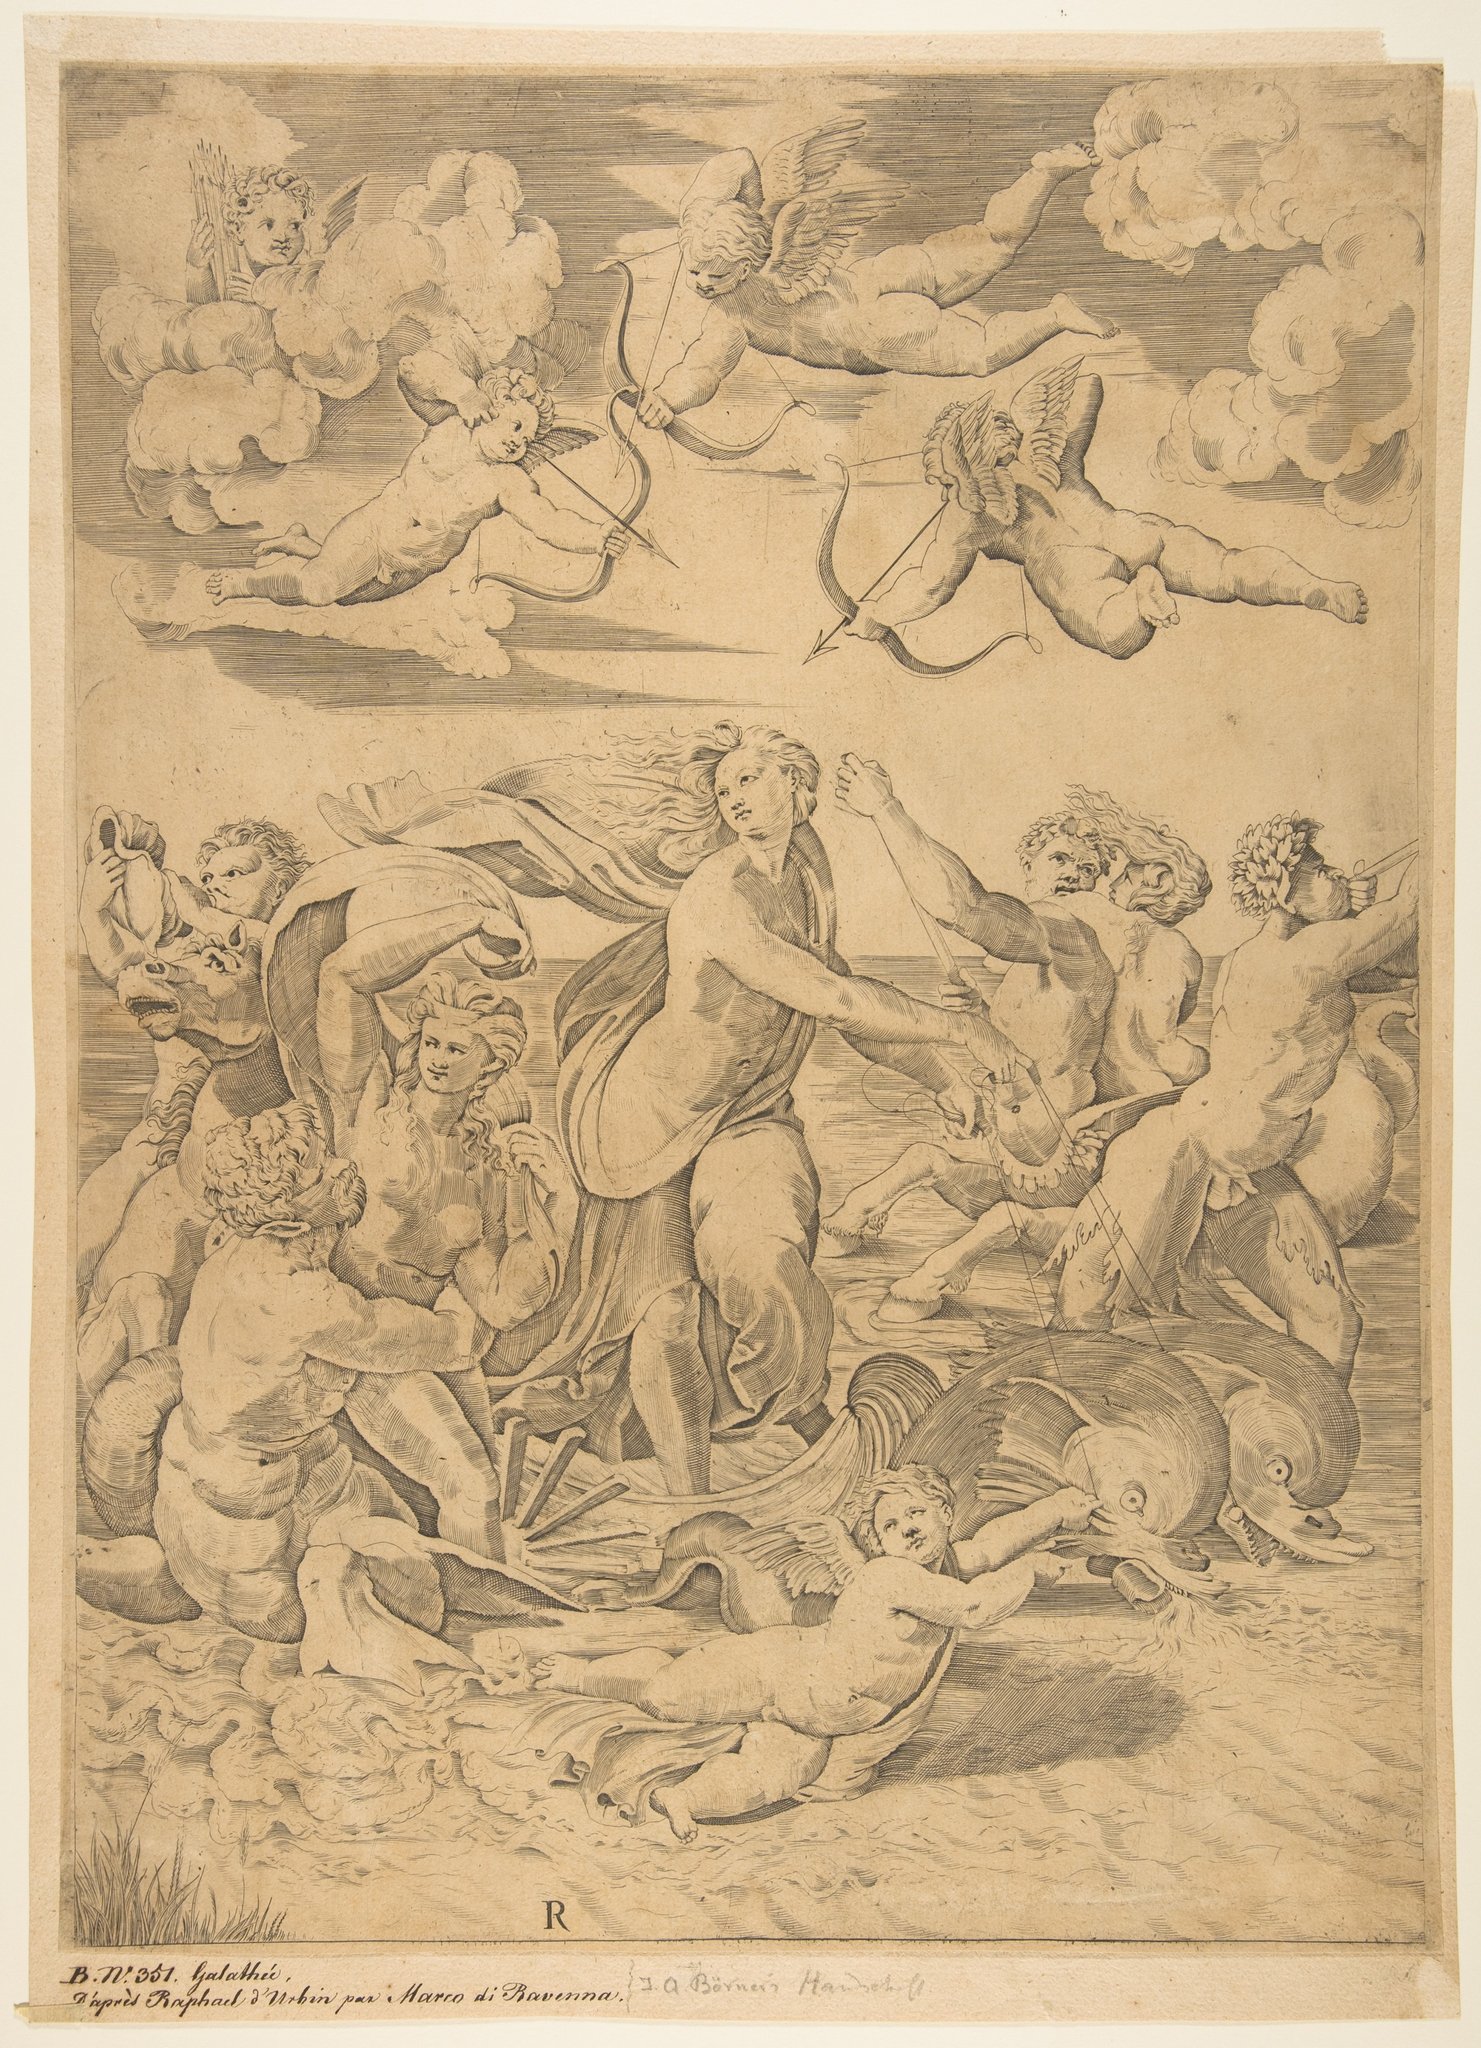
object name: print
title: Galatea riding in a shell pulled through the water by dolphins, a cupid below and four more above, at left a triton embracing a nymph and behind them a man on horseback blowing a conch, at right a figure blowing a horn and behind him a nymph riding on a centaur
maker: marco dente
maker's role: artist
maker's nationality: italian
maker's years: 1515-1527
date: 1515-1527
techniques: engraving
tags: cupid,galatea,centaurs,nymphs,dolphins